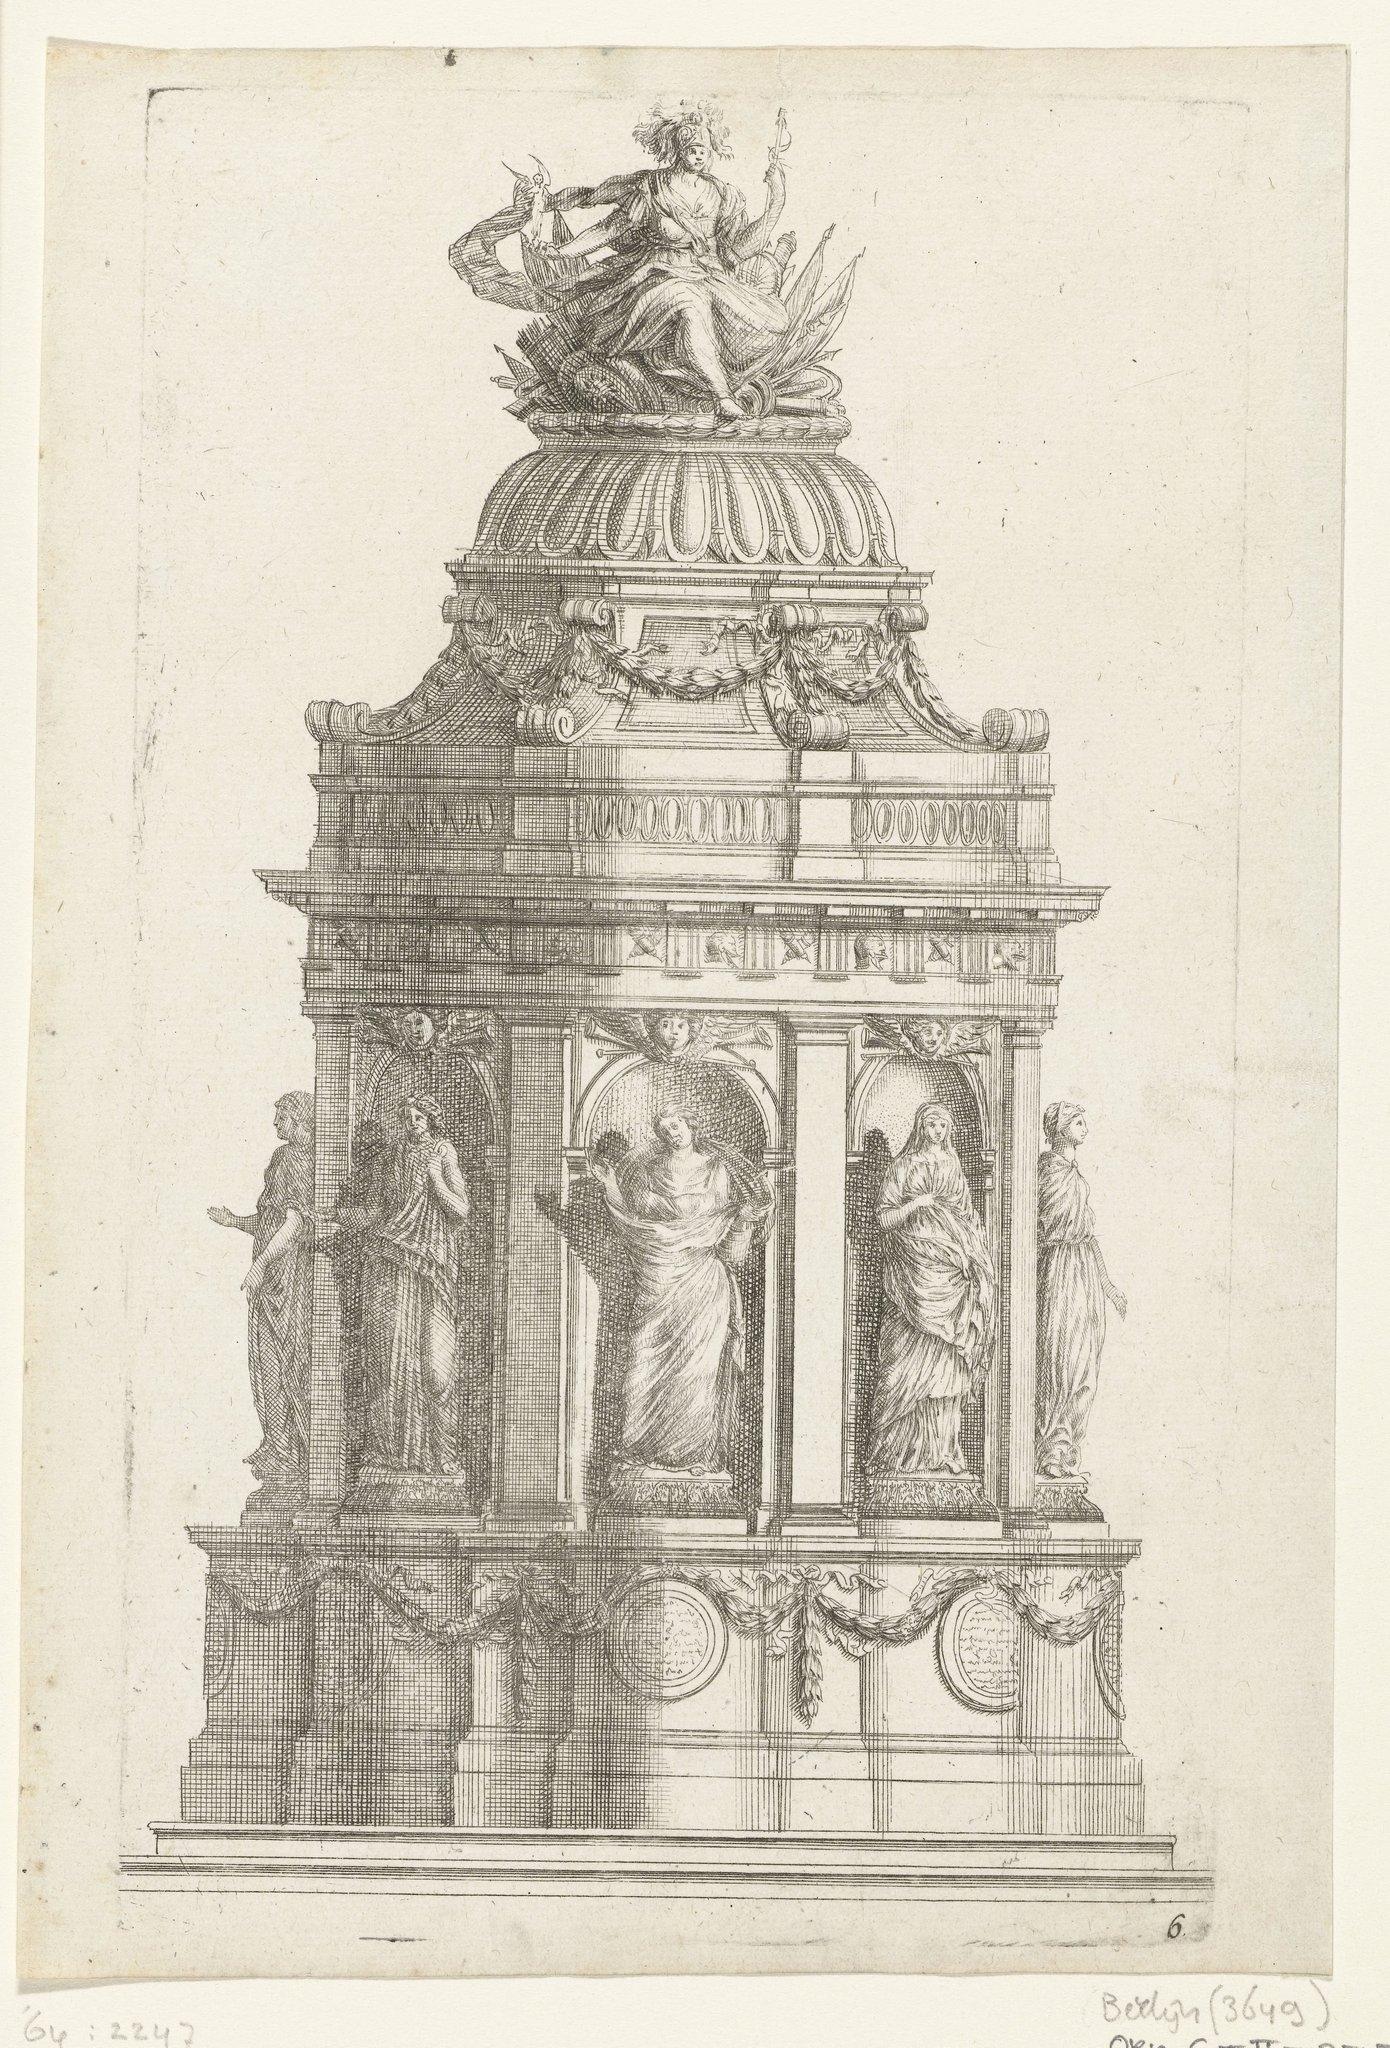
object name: ornament print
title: Grafmonument in de vorm van een tempietto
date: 1629-1716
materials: paper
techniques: engraving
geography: paris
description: In de nissen staan beelden, bovenop zit Minerva op een wapentrofee. Uit eerste editie.